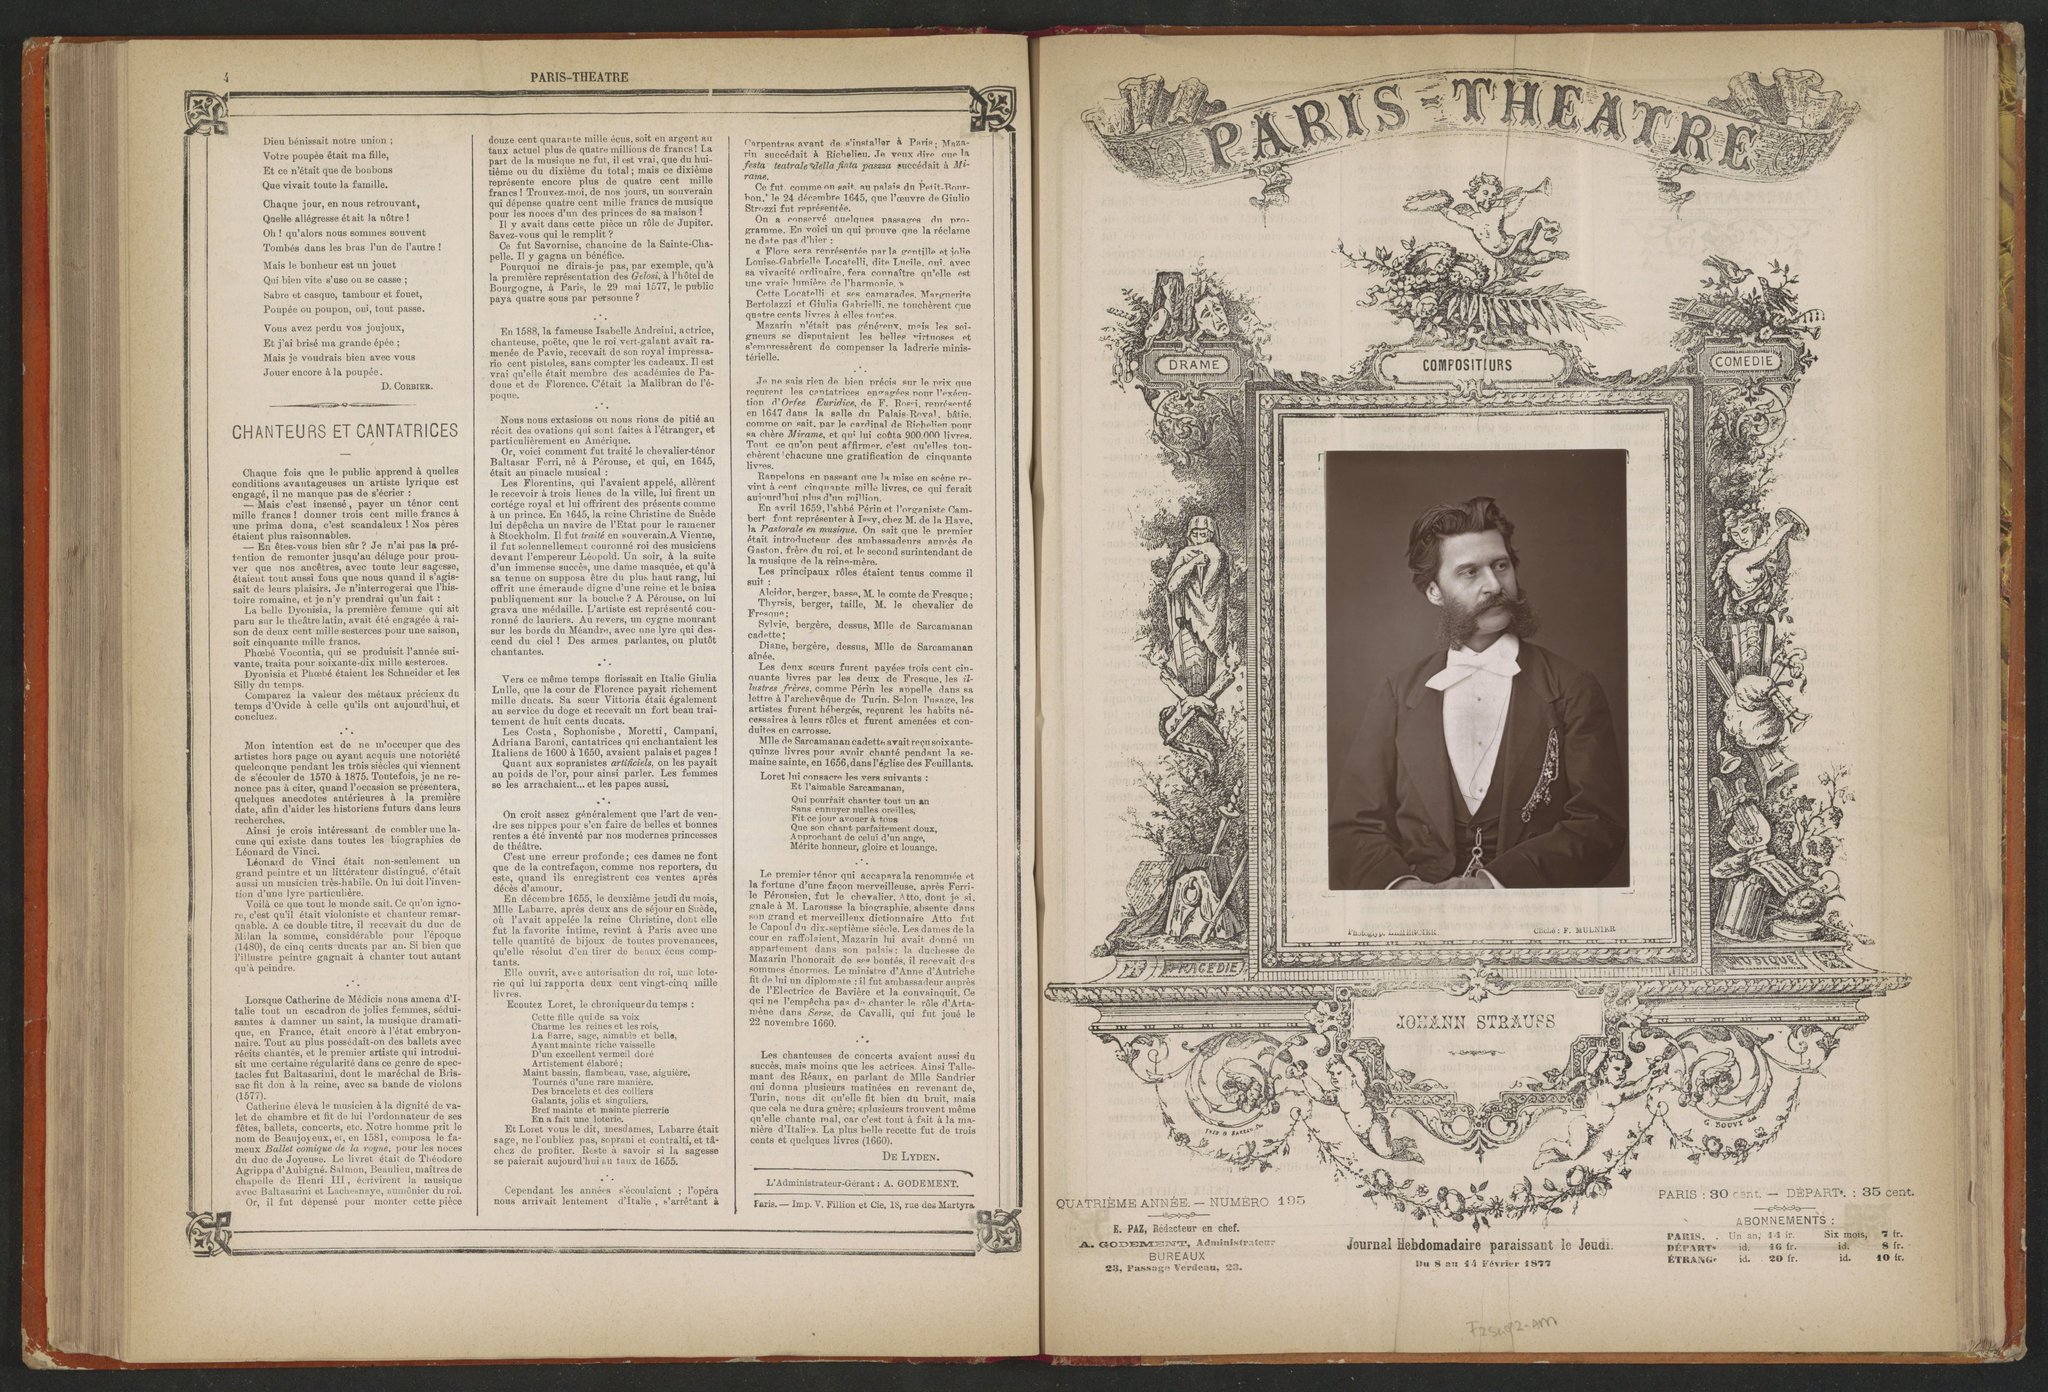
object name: photomechanical print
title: Portret van Johann Strauss jr.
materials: paper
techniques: woodburytype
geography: france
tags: composer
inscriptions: inscription: ‘Journal Hebdomadaire paraissant le Jeudi, Du 8 au 14 Février 1877’, number: ‘Numéro 195’